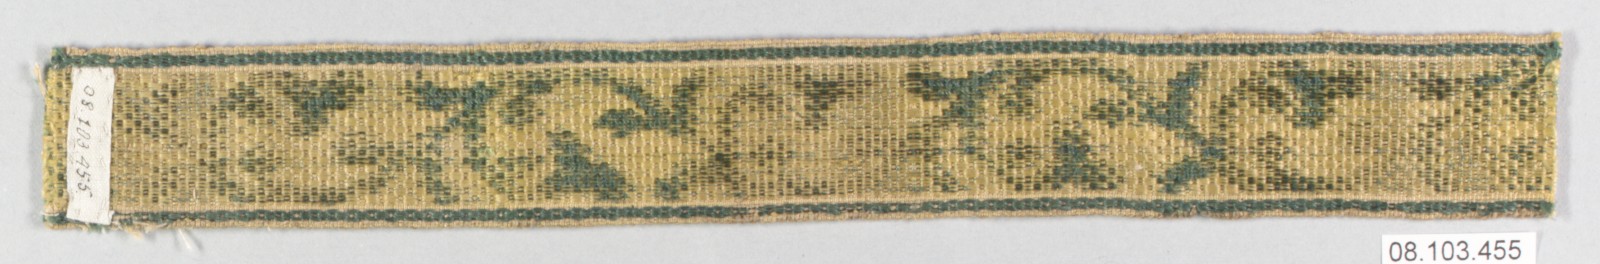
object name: galloon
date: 1801-1833